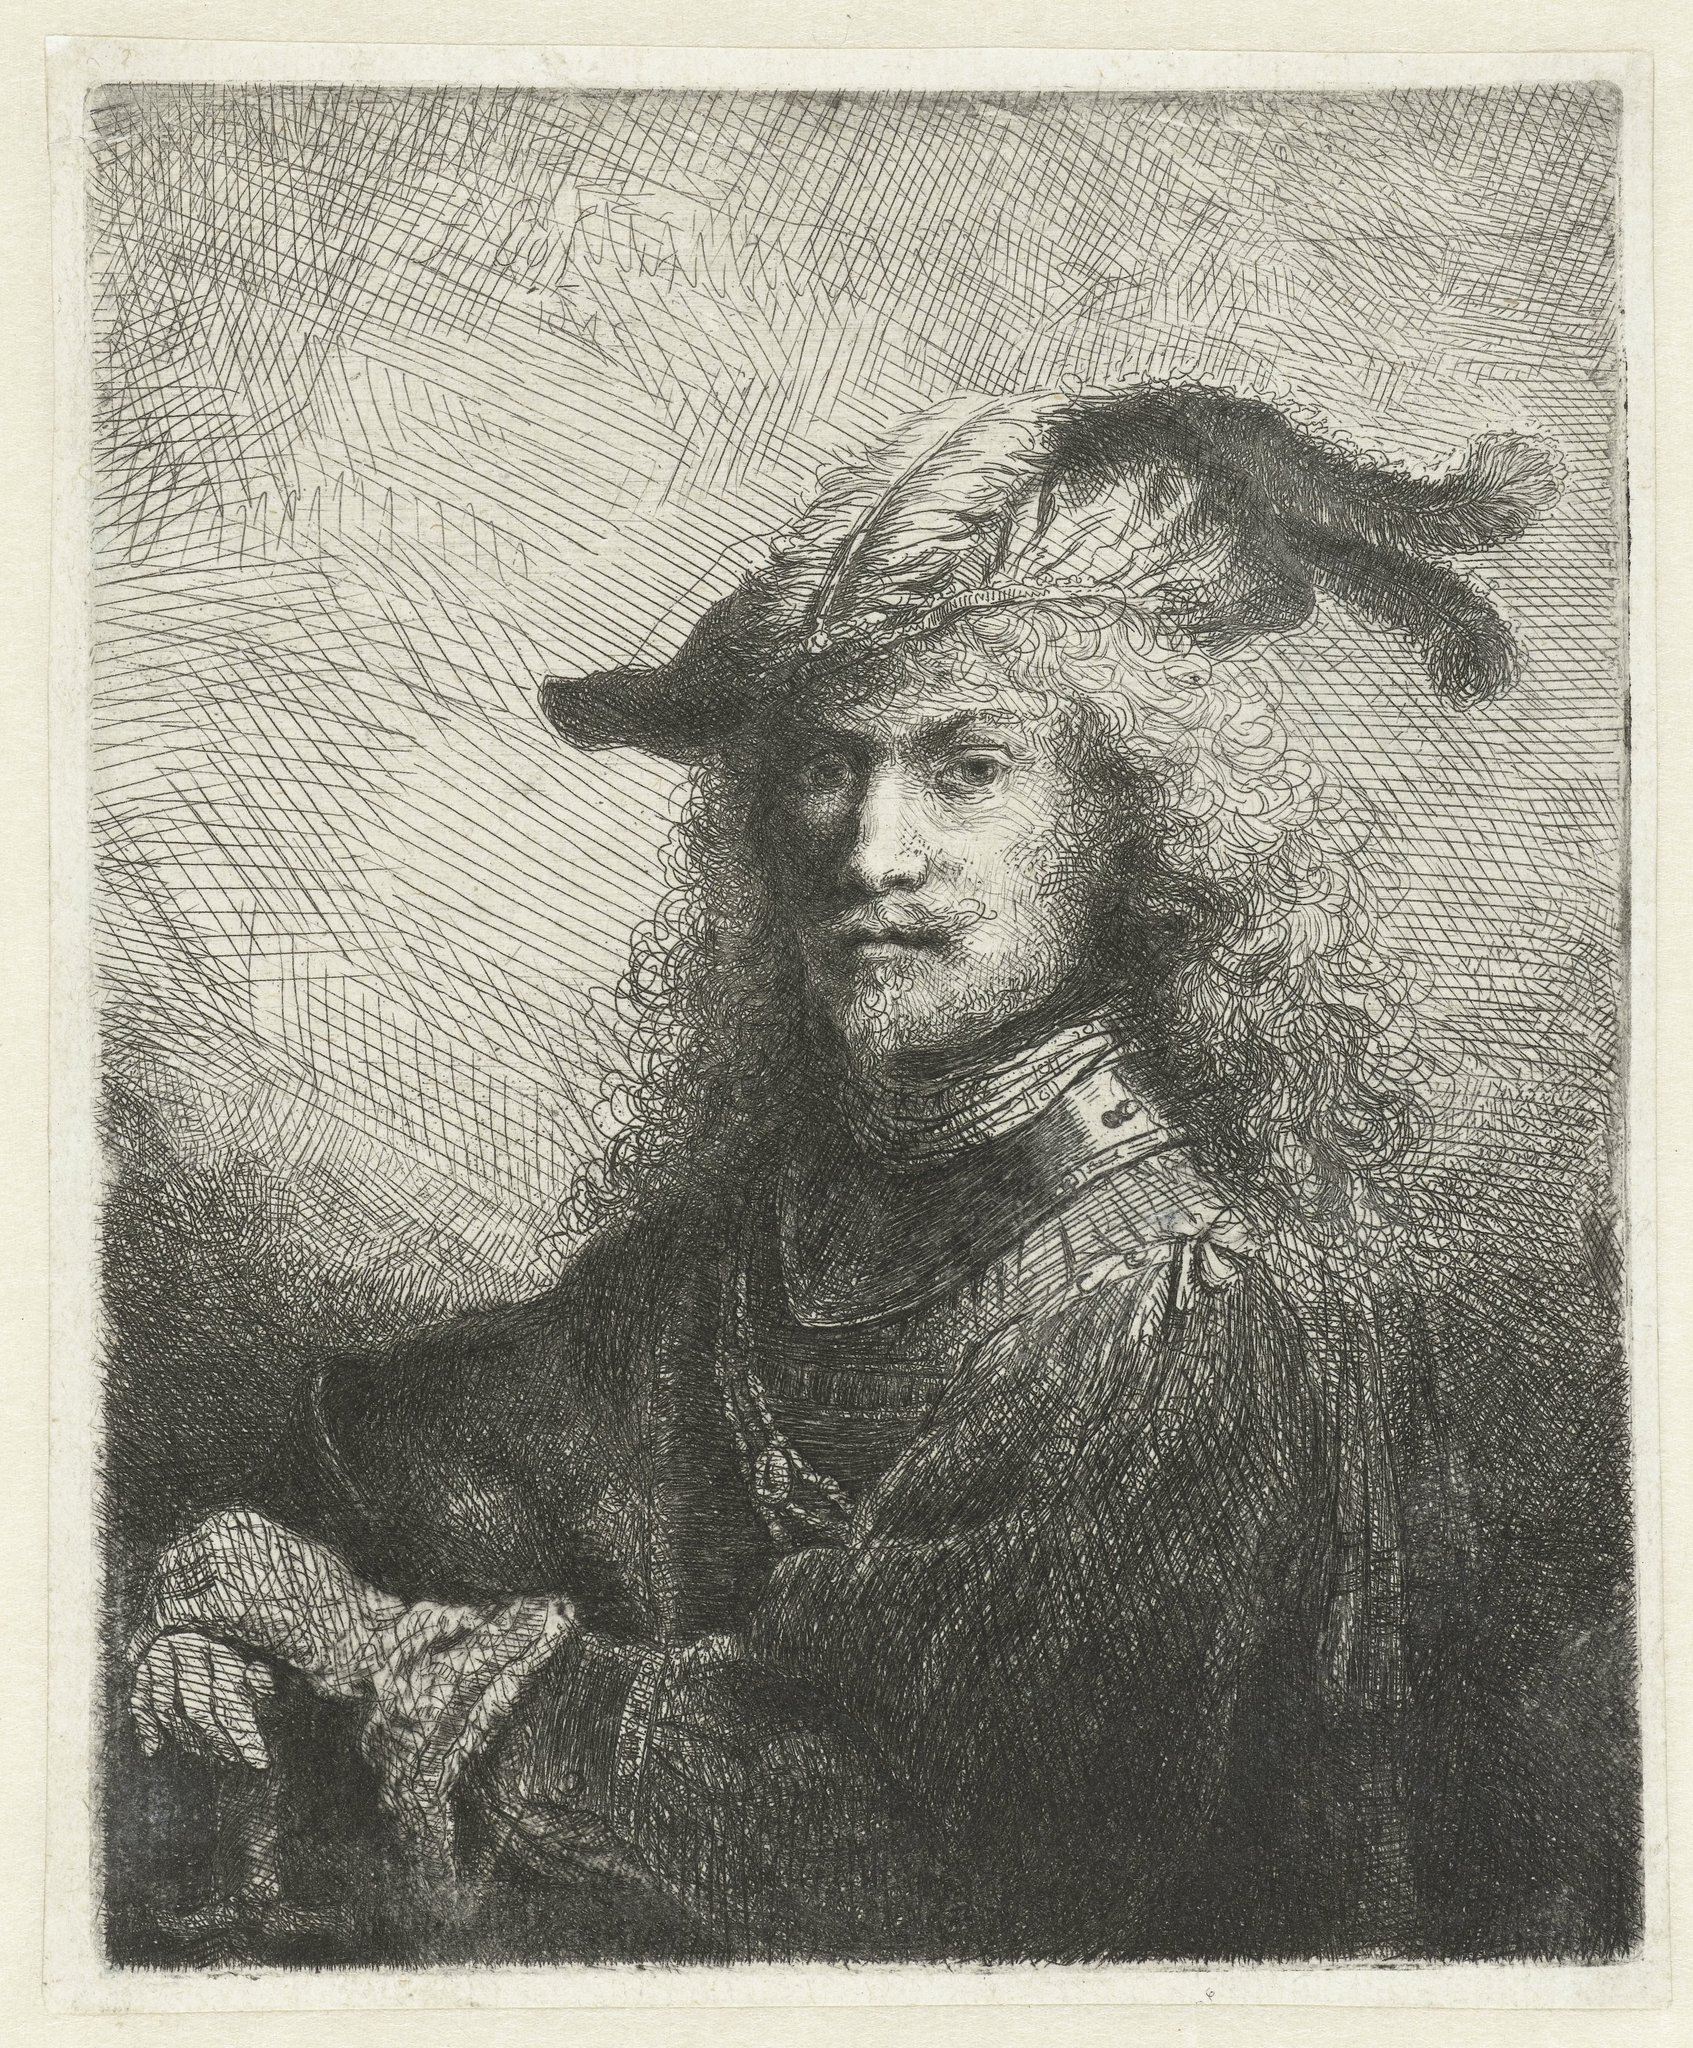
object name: print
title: Portret van een officier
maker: ferdinand bol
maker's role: draughtsman, painter, print maker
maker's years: 1616-1680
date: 1642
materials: paper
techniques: drypoint, etching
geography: amsterdam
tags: portrait, self-portrait of artist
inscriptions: collector's mark: Lugt 240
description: Mogelijk een zelfportret als grand seigneur